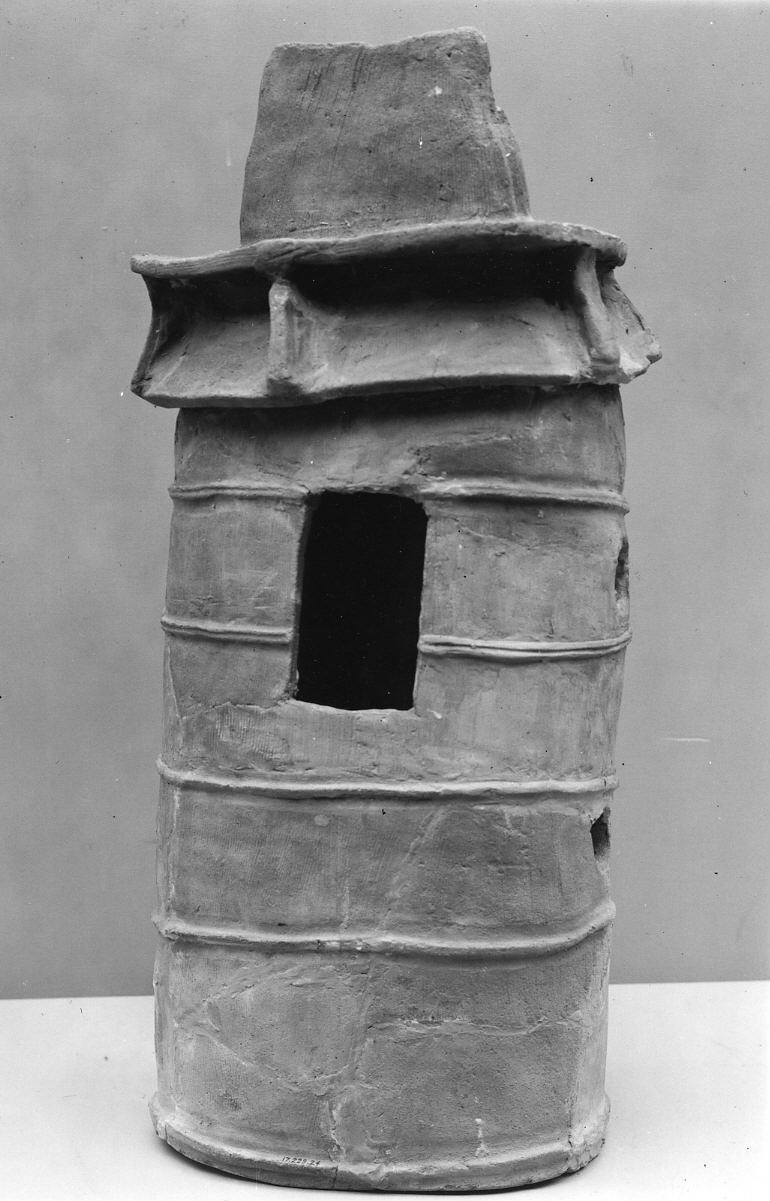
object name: haniwa model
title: Haniwa House of the Period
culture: japanese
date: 201-700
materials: earthenware